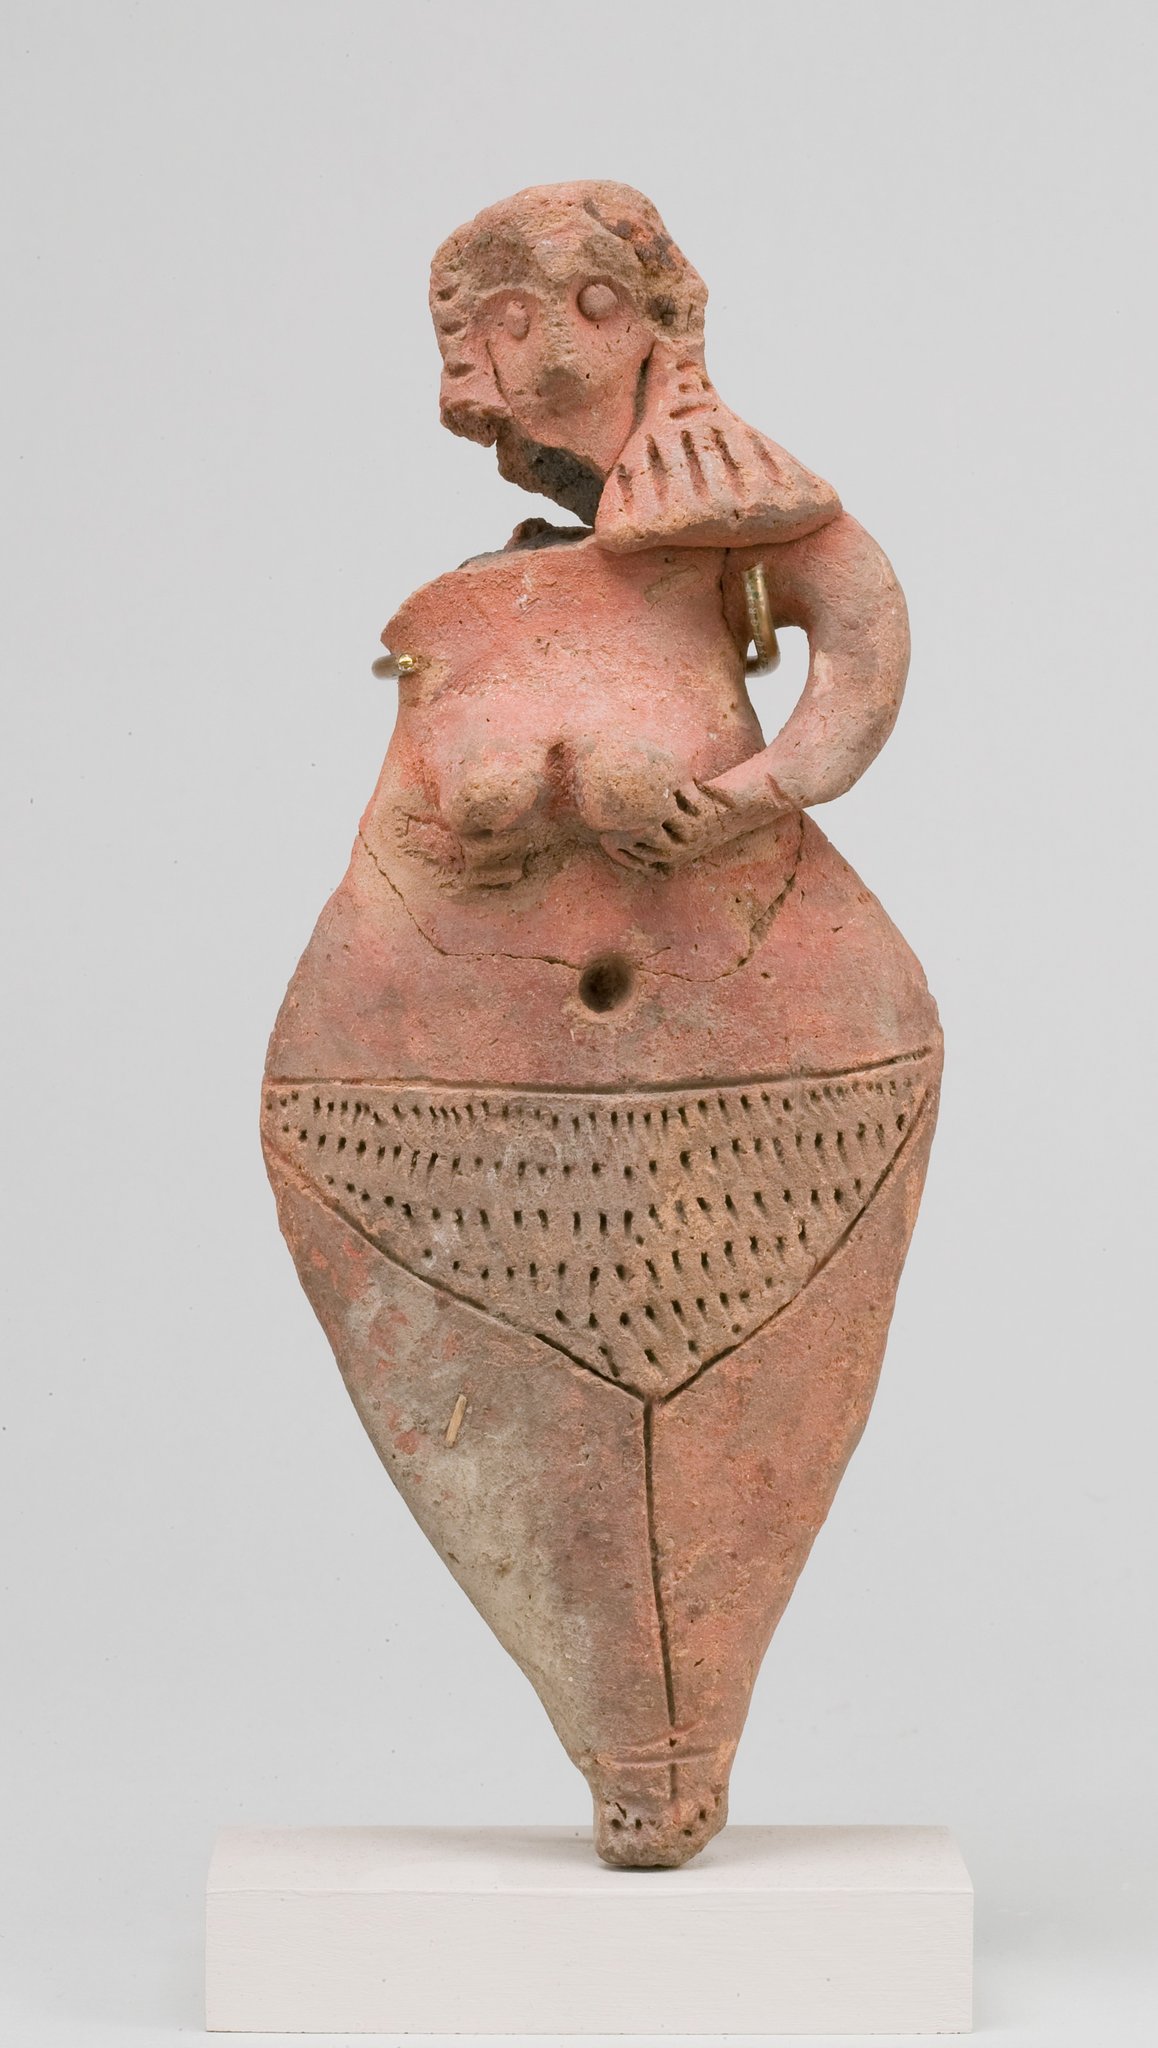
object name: statuette of a woman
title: Statuette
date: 1550-1295 BCE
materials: pottery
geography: egypt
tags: female nudes